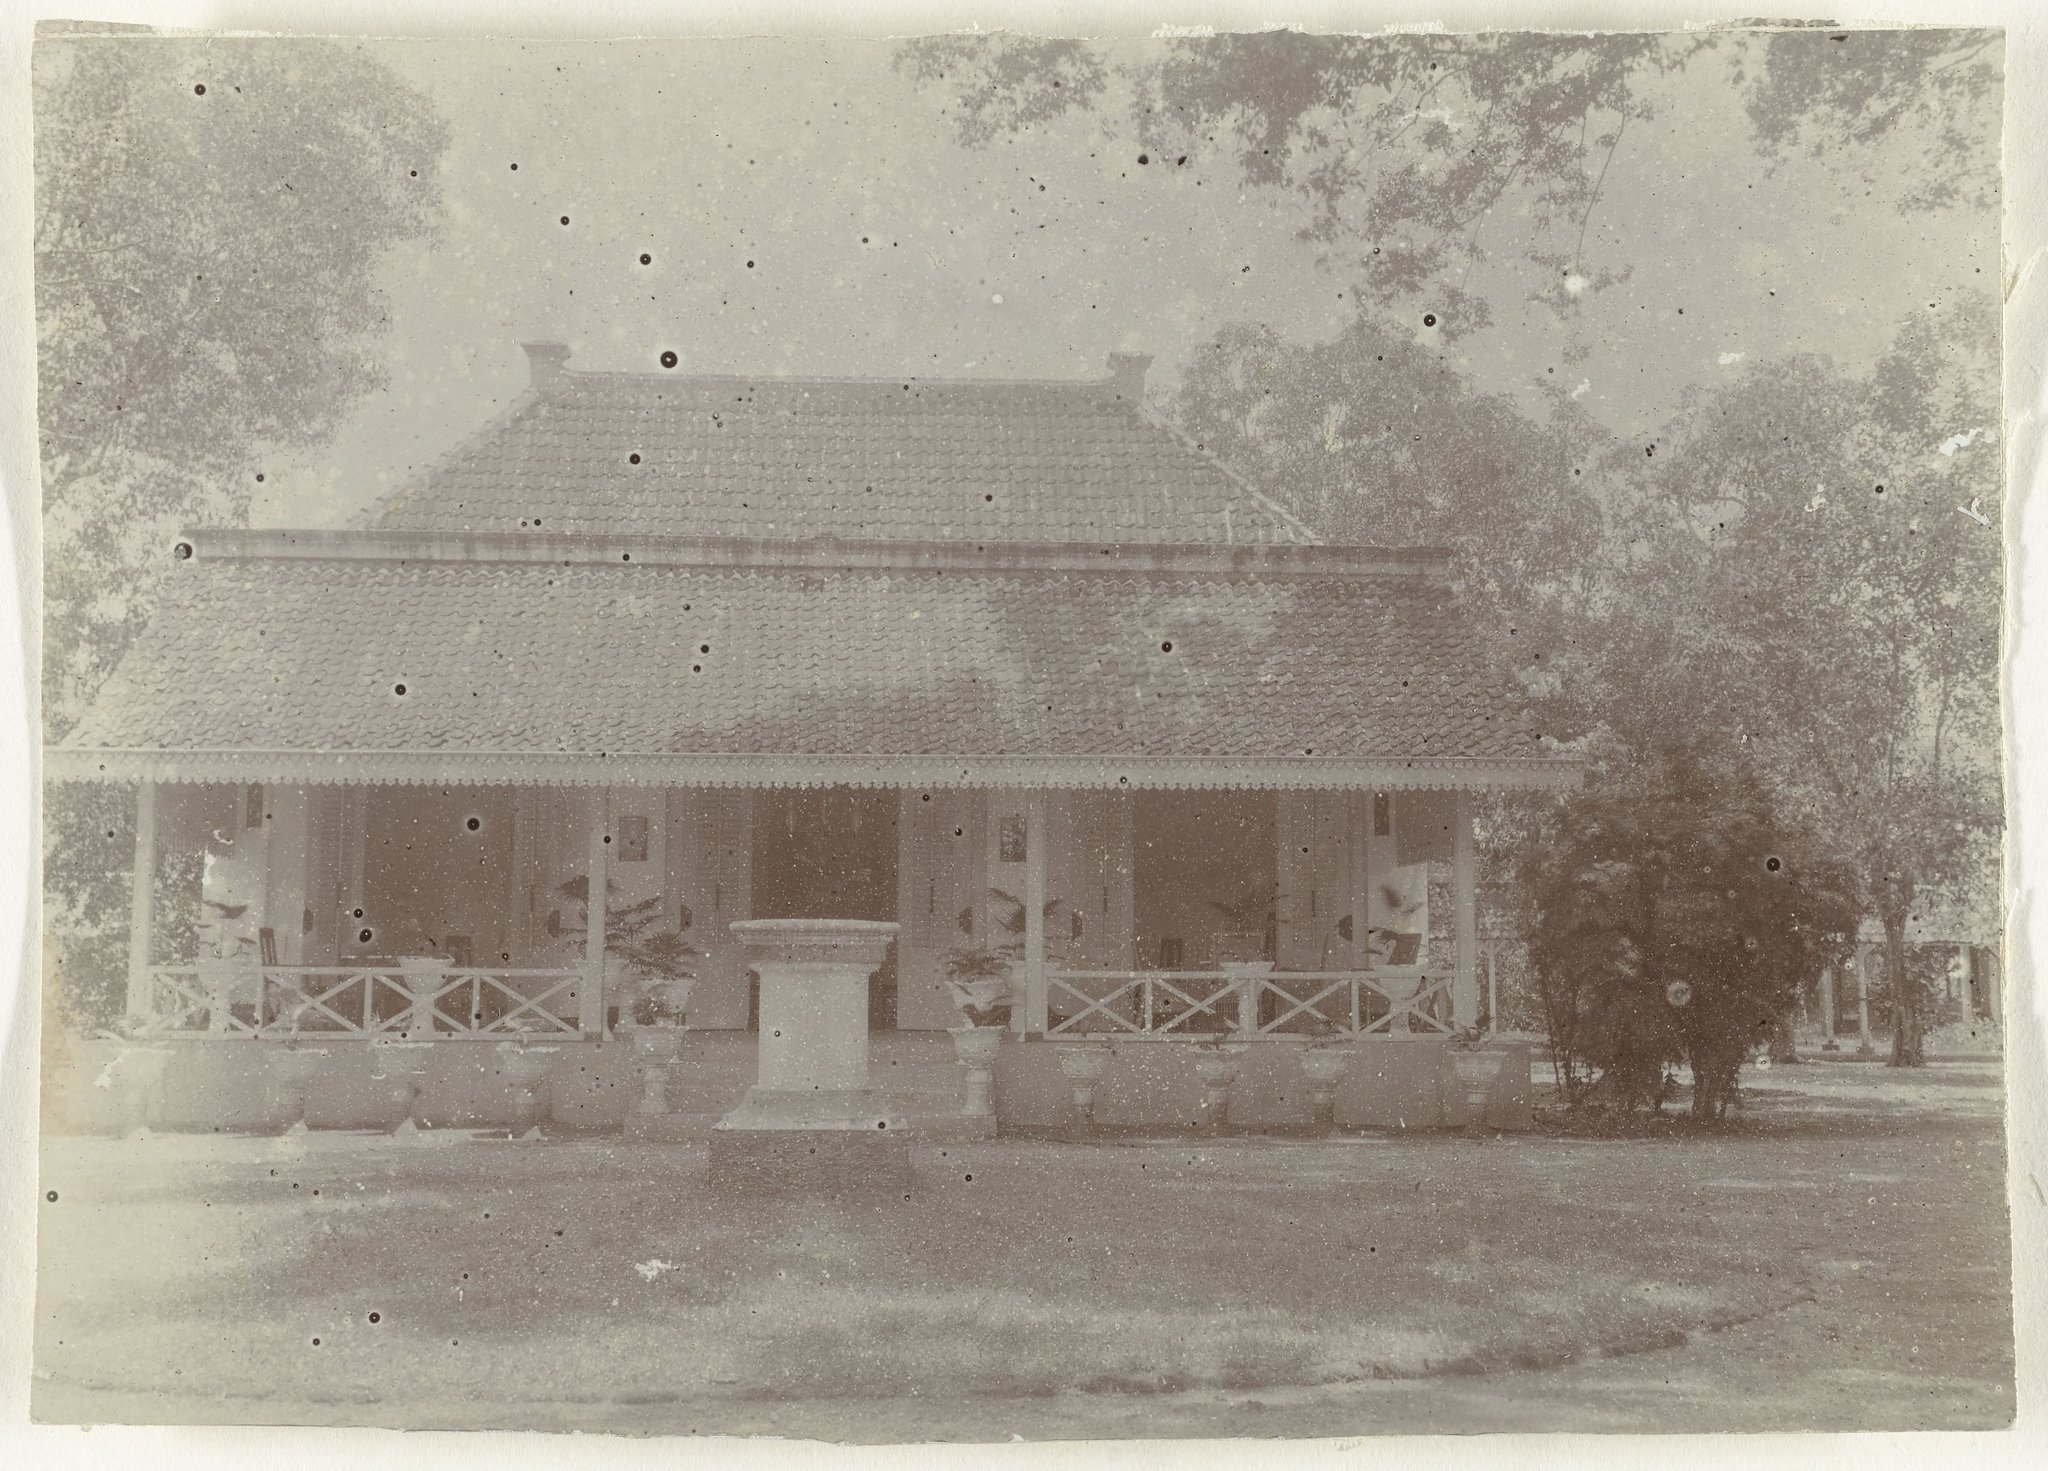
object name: photograph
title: Woning te Mojokerto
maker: Anonymous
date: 1910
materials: photographic support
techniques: photography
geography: mojokerto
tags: housing